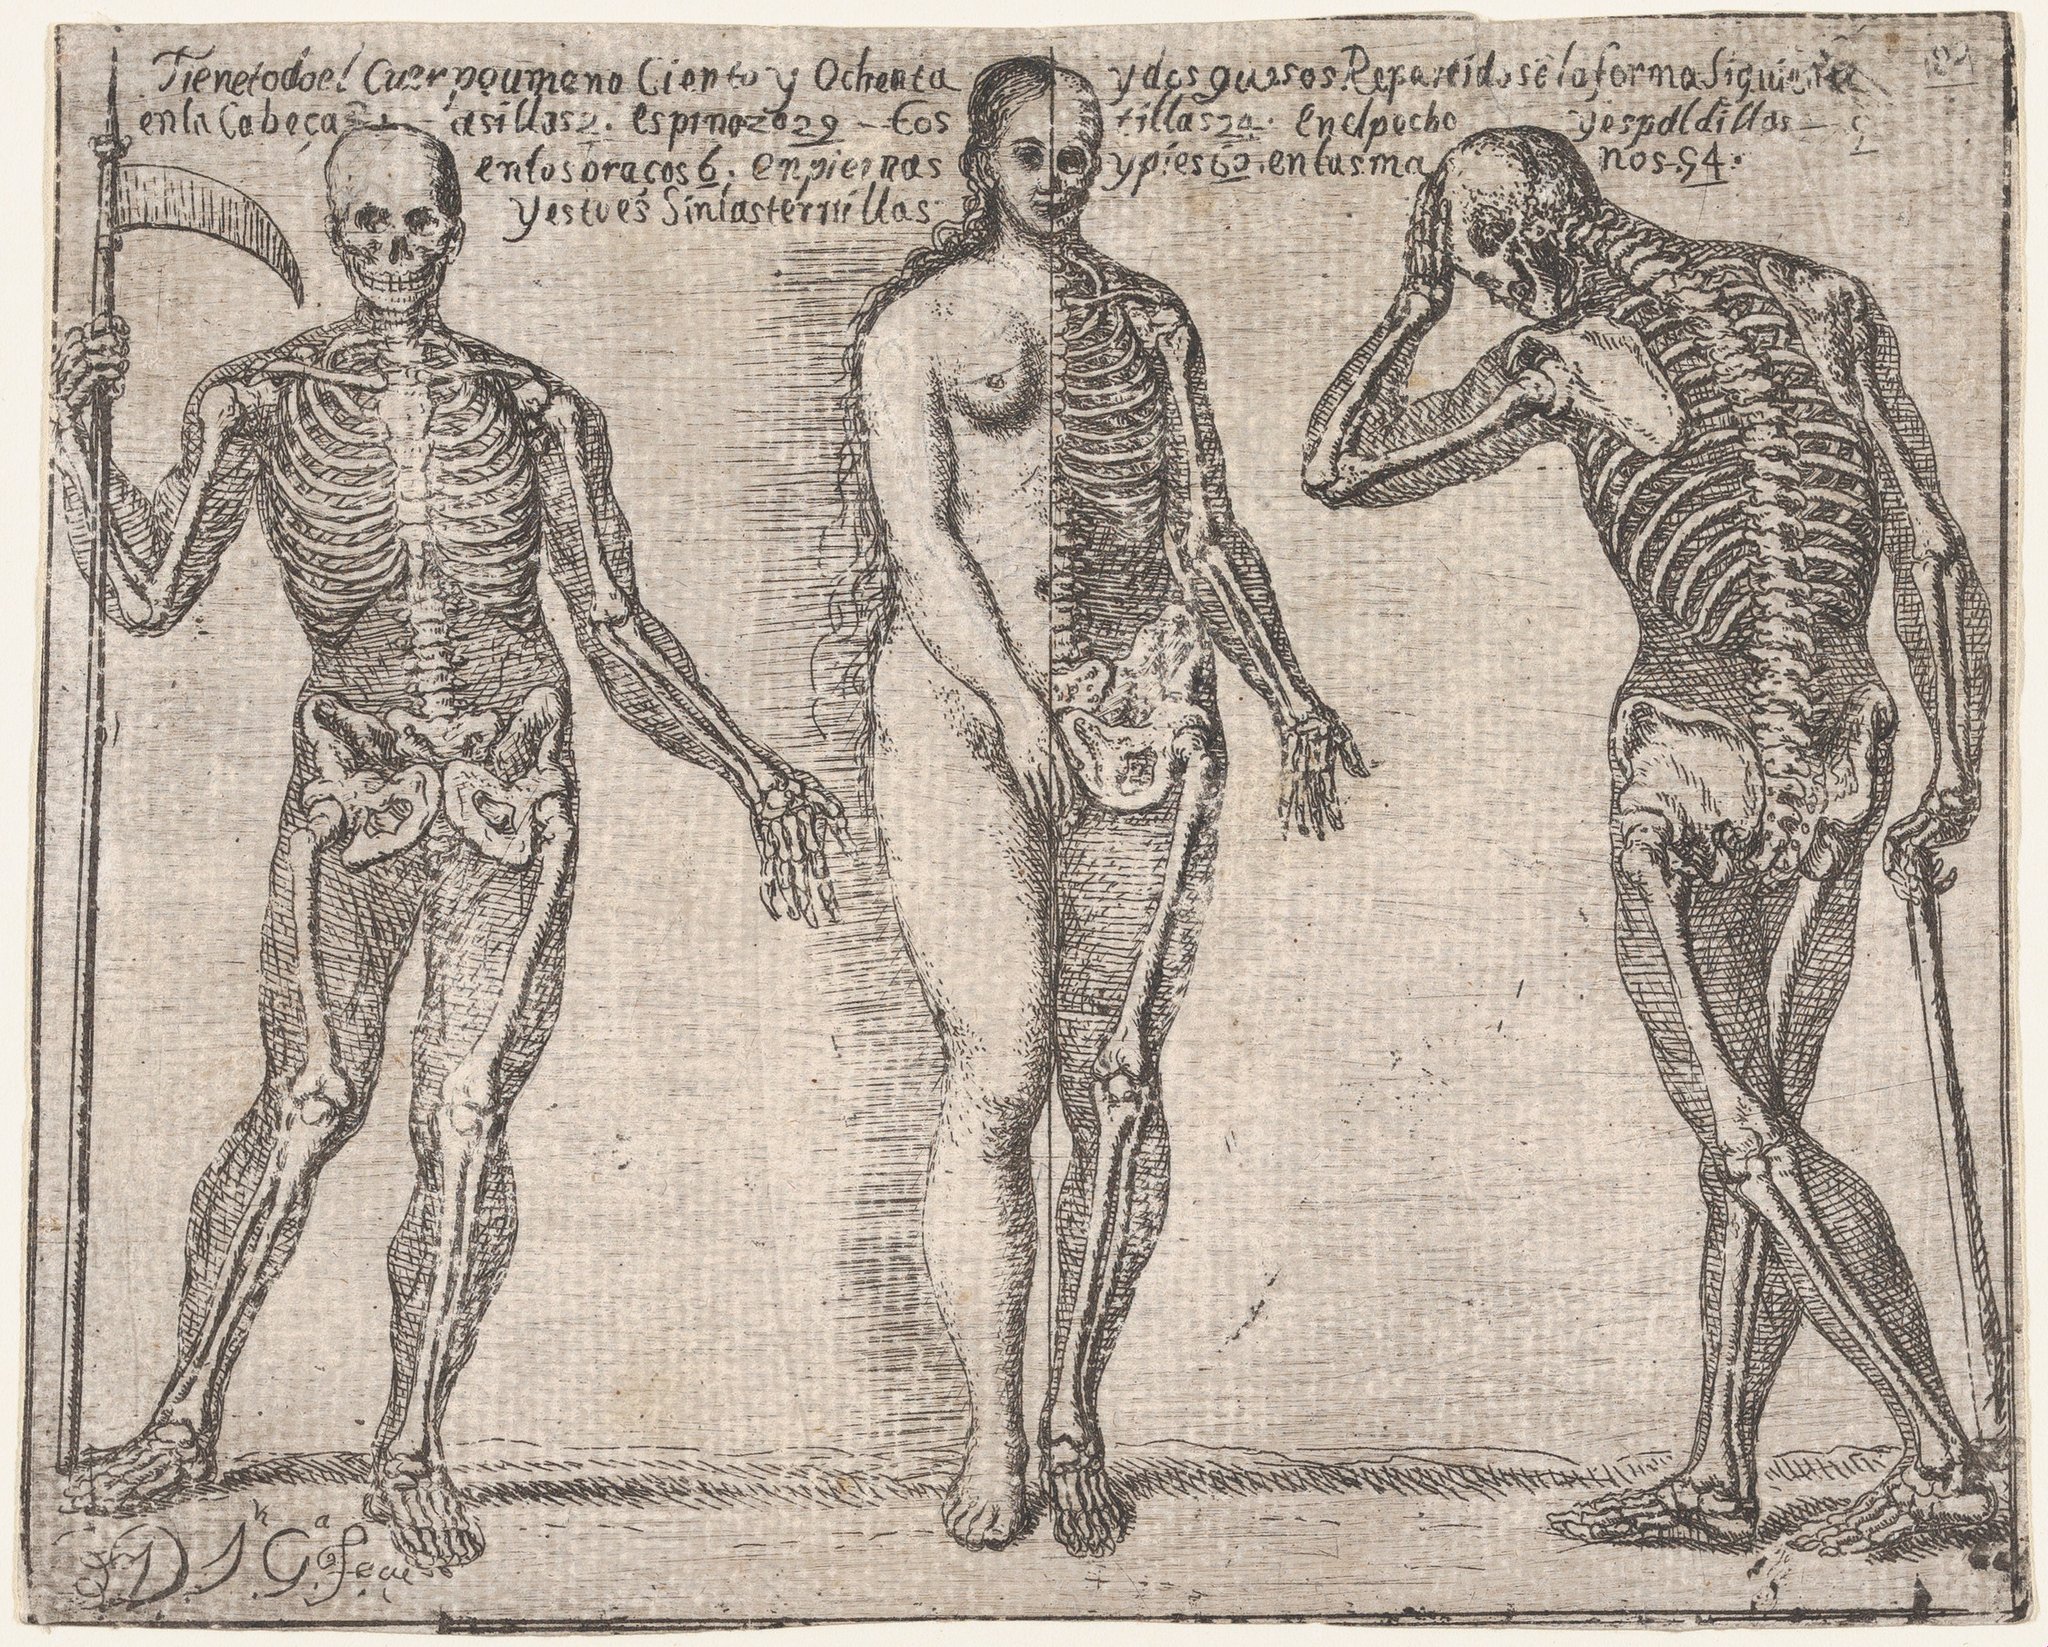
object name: print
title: Studies of three skeleton, from the 'Principios para estudiar el Nobilísimo y Real arte de la Pintura' (Madrid 1693)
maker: josé garcía hidalgo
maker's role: artist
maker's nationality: spanish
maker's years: 1645-1717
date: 1693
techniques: etching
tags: skeletons